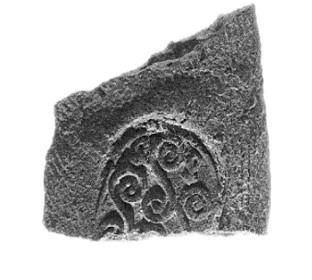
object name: sealing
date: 1981-1640 BCE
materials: mud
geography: egypt